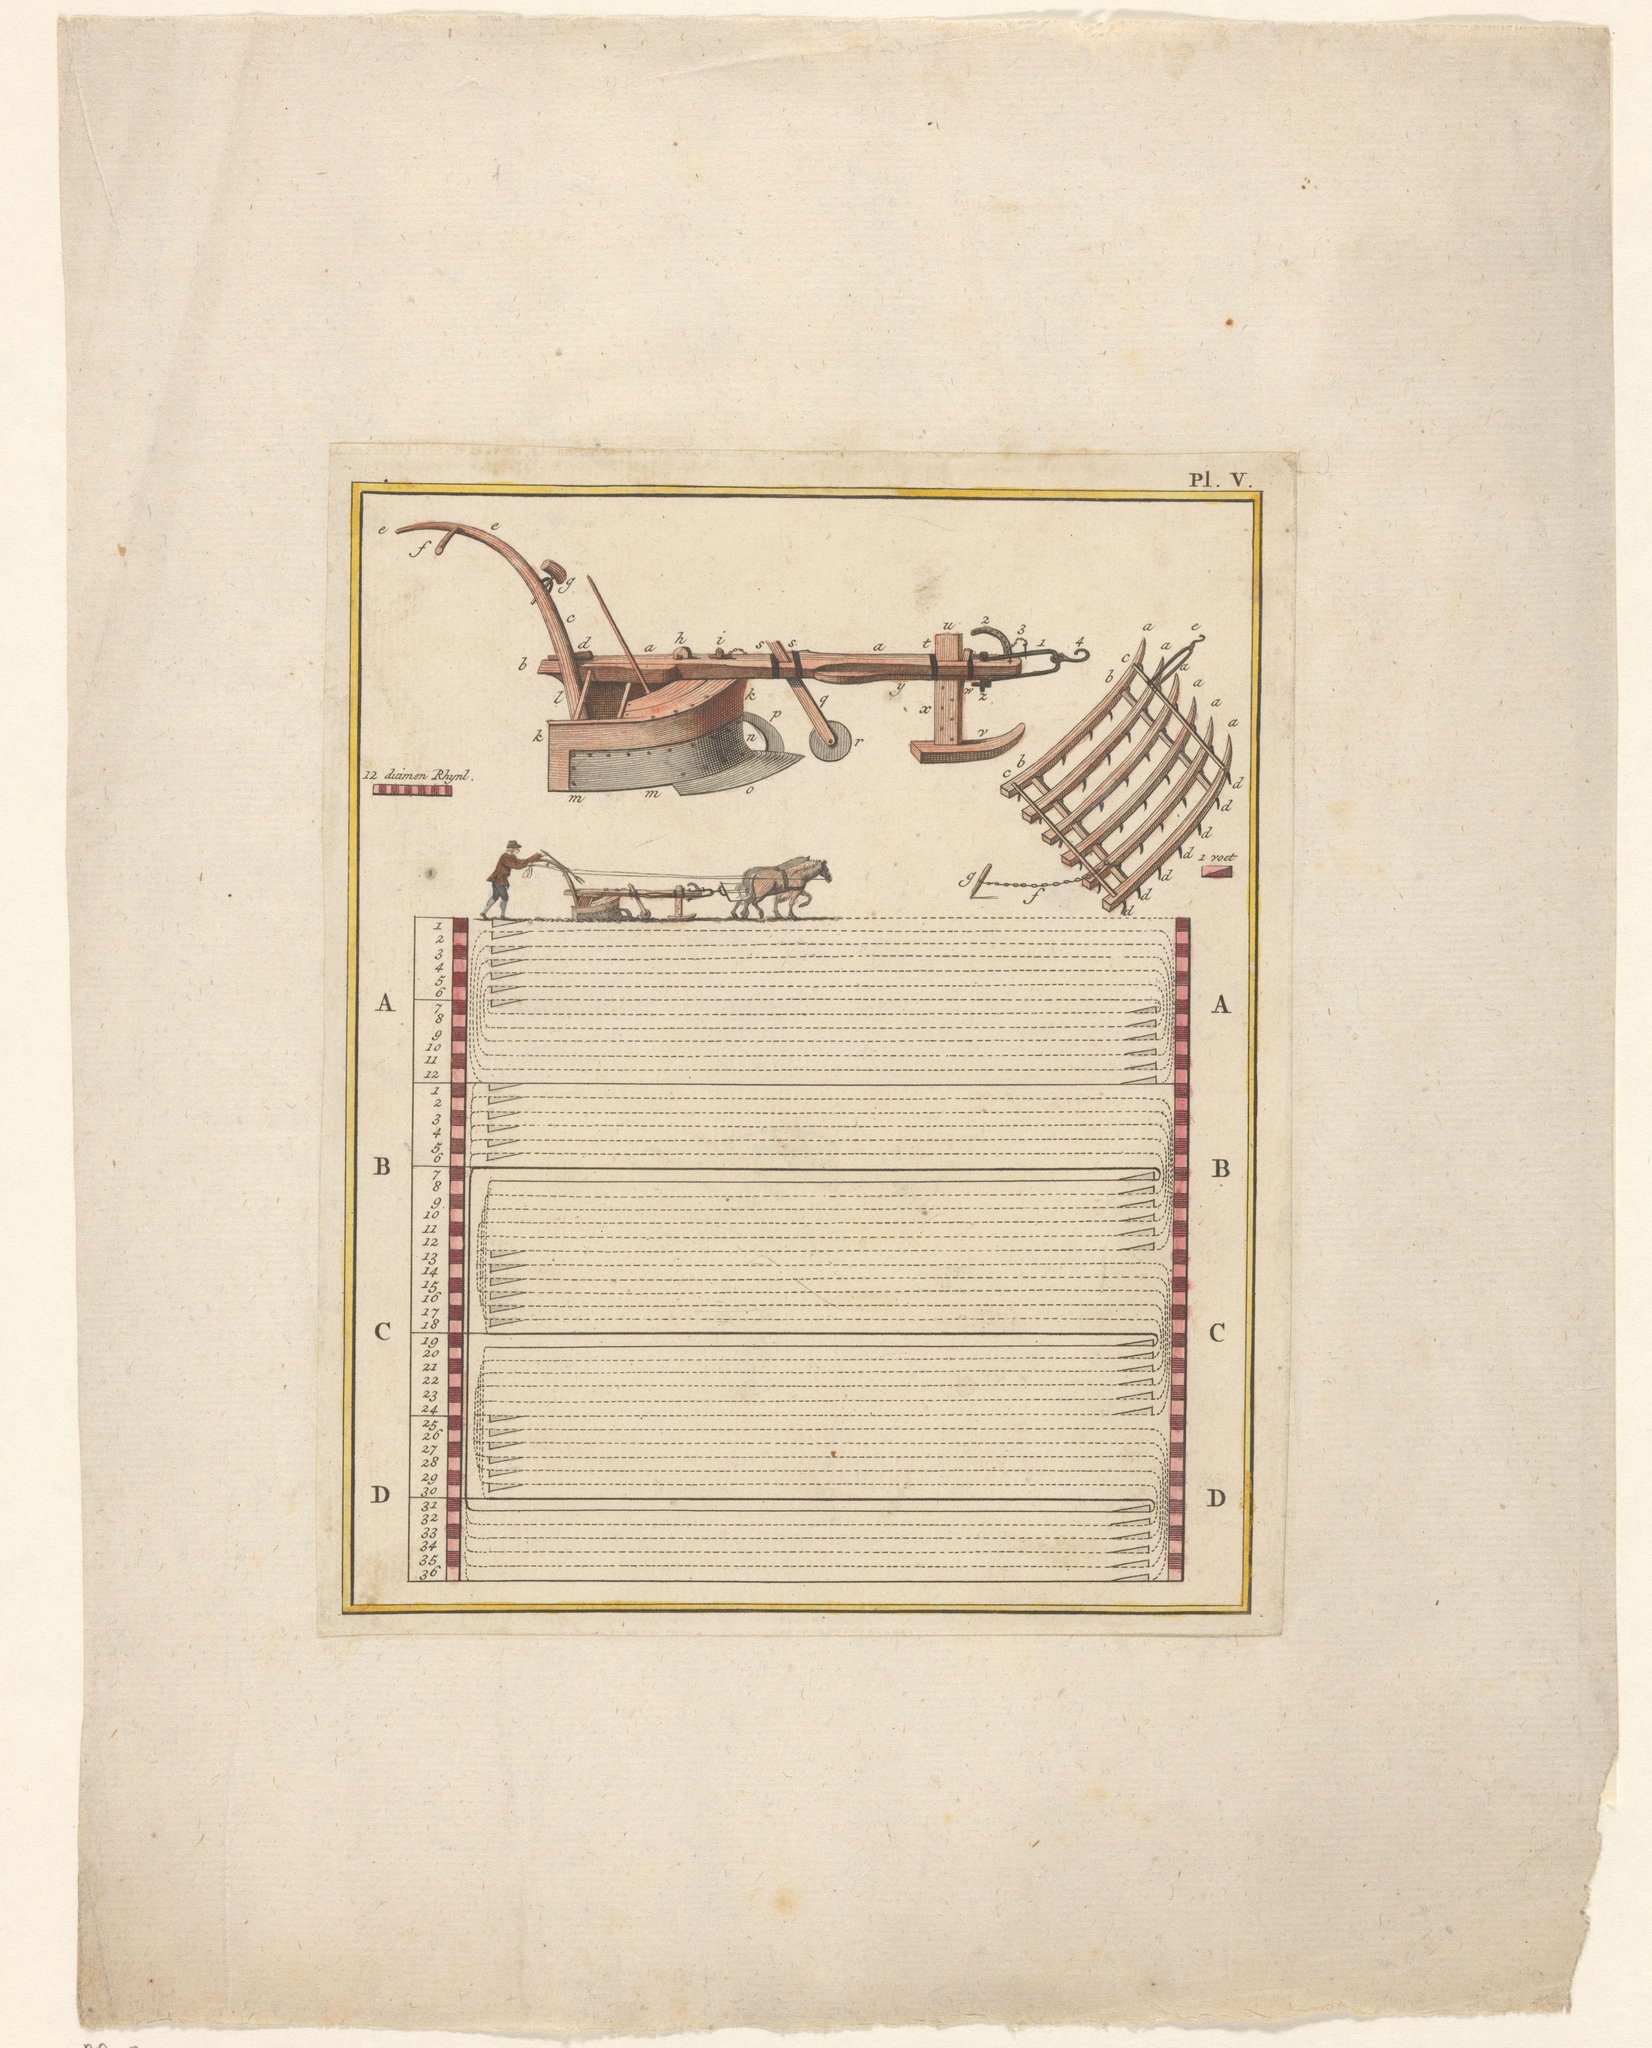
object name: print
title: Ploeg met uitleg tot hantering en het trekken van voren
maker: Anonymous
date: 1750-1850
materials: paper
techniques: etching, hand coloring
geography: netherlands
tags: ploughed field, agricultural implements: plough, ploughing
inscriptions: collector's mark: Lugt 2228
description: Prent gebruikt in: Le Francq van Berkhey, Joannes. Natuurlyke historie van Holland. 4 dln. Amsterdam: Jacob Yntema en Jacob Tieboel, dl. 2, 1771, p. 330/331.